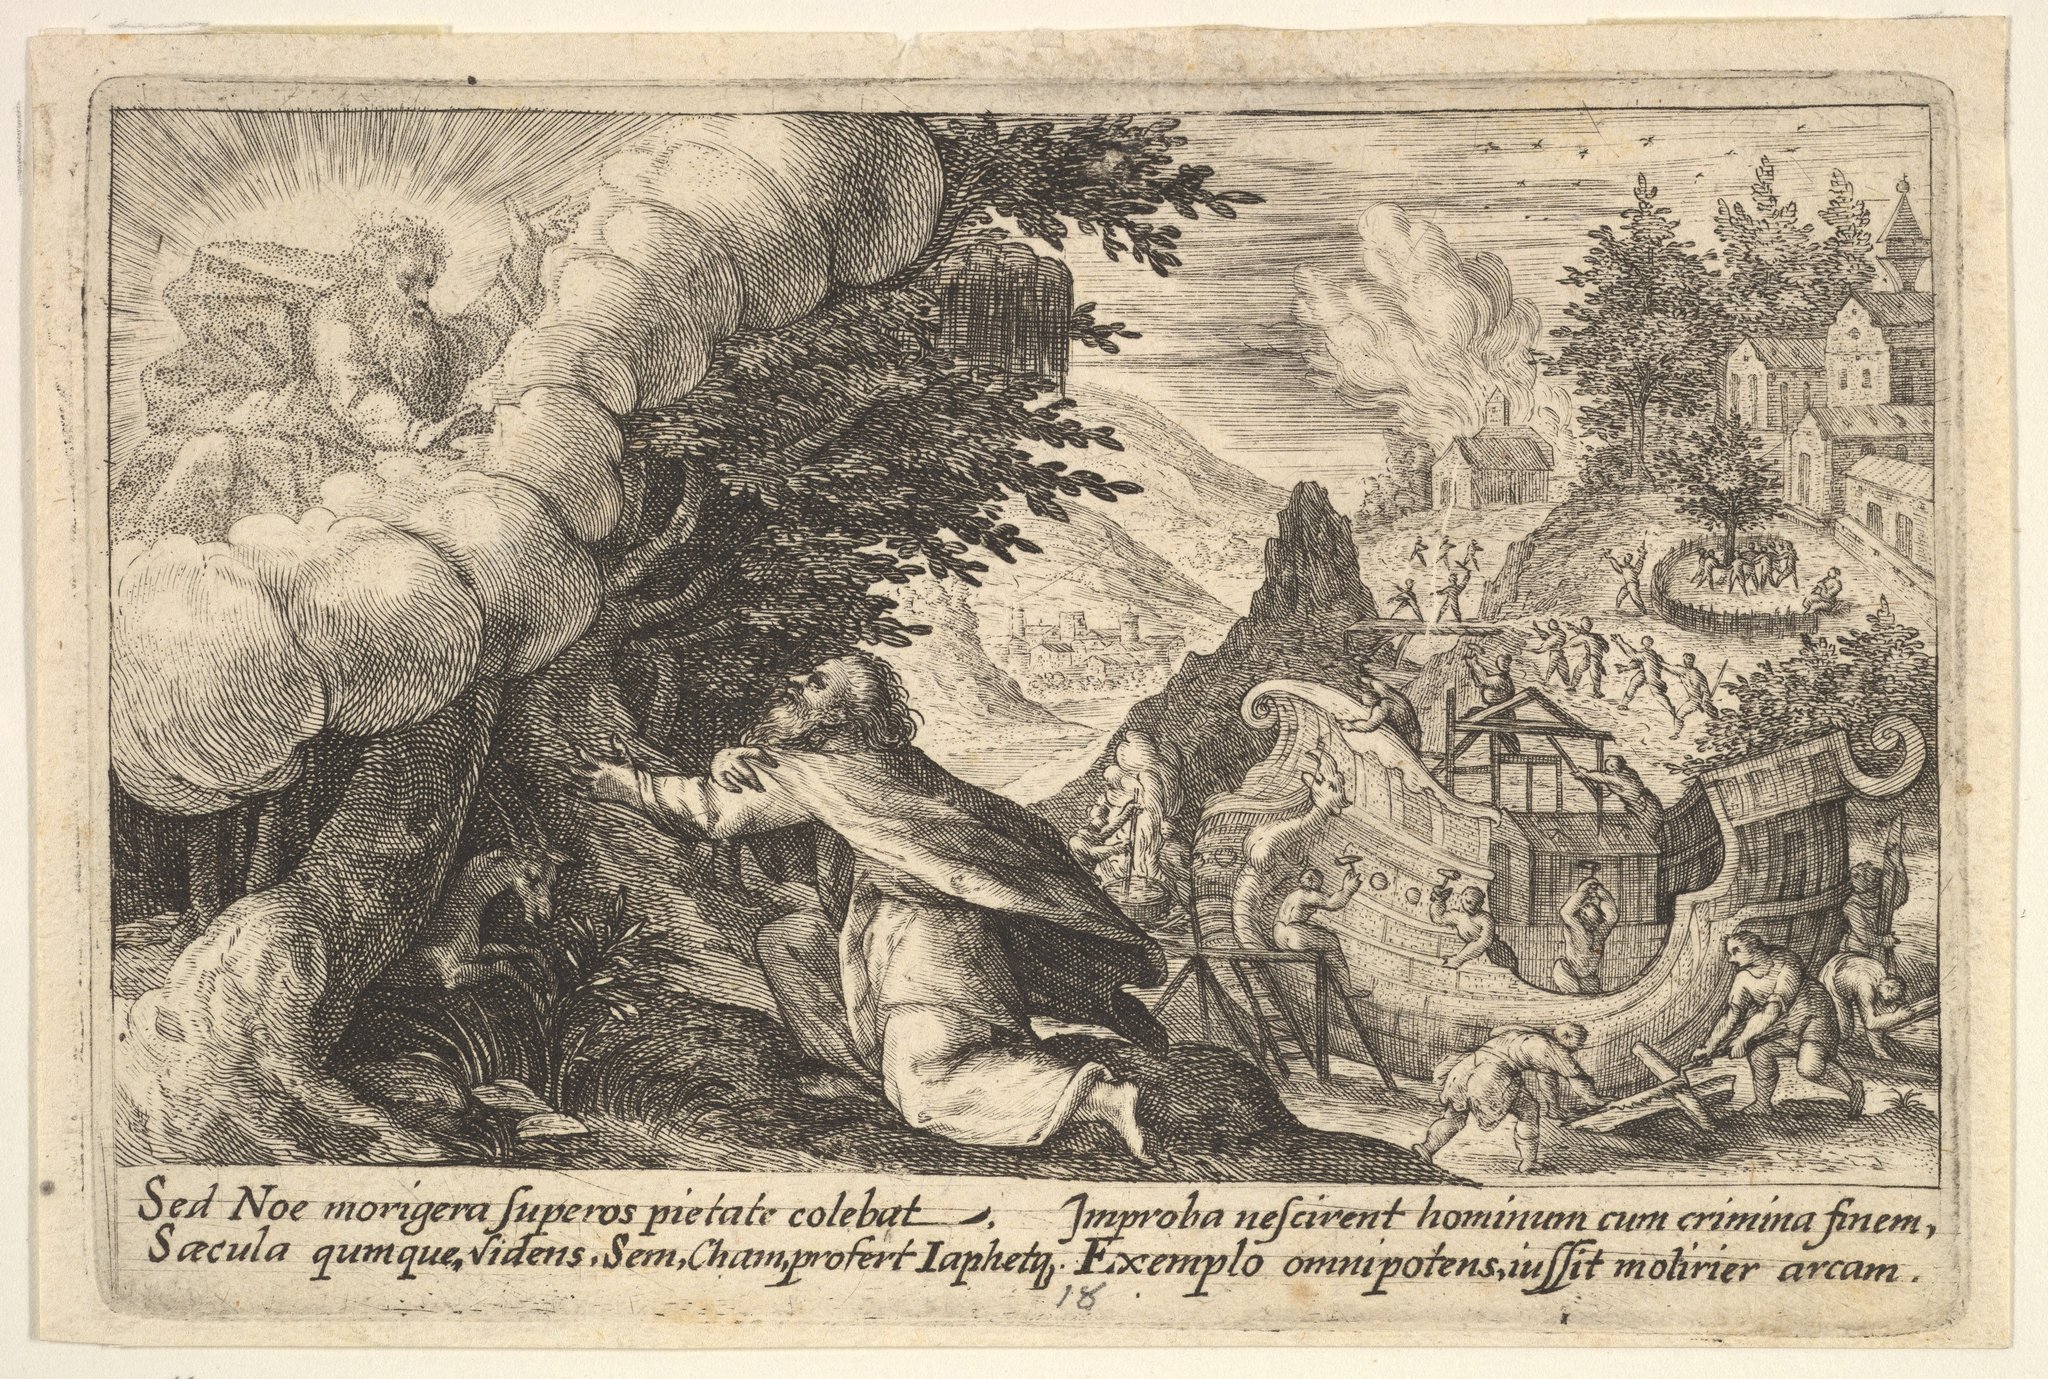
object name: print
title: Noah kneeling before God at left, the construction of the ark underway beyond, from "Liber Genesis"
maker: crispijn de passe the elder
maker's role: artist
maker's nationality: netherlandish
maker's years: 1564-1637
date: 1612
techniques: engraving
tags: men,working,boats,god the father,noah